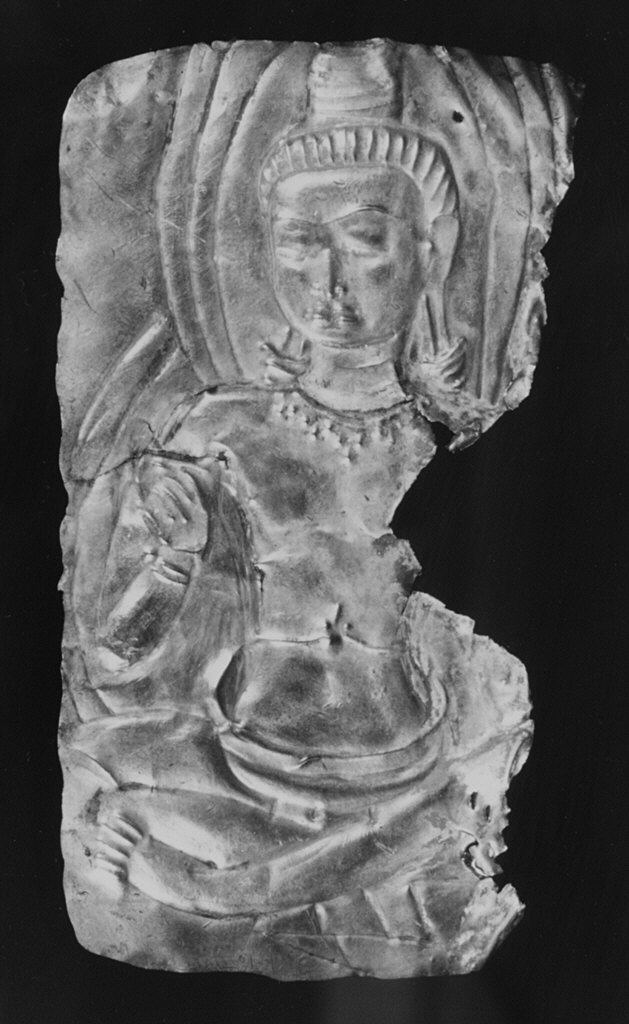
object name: votive plaque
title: Seated Bodhisattva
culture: thai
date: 701-800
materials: gold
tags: buddhism,bodhisattvas